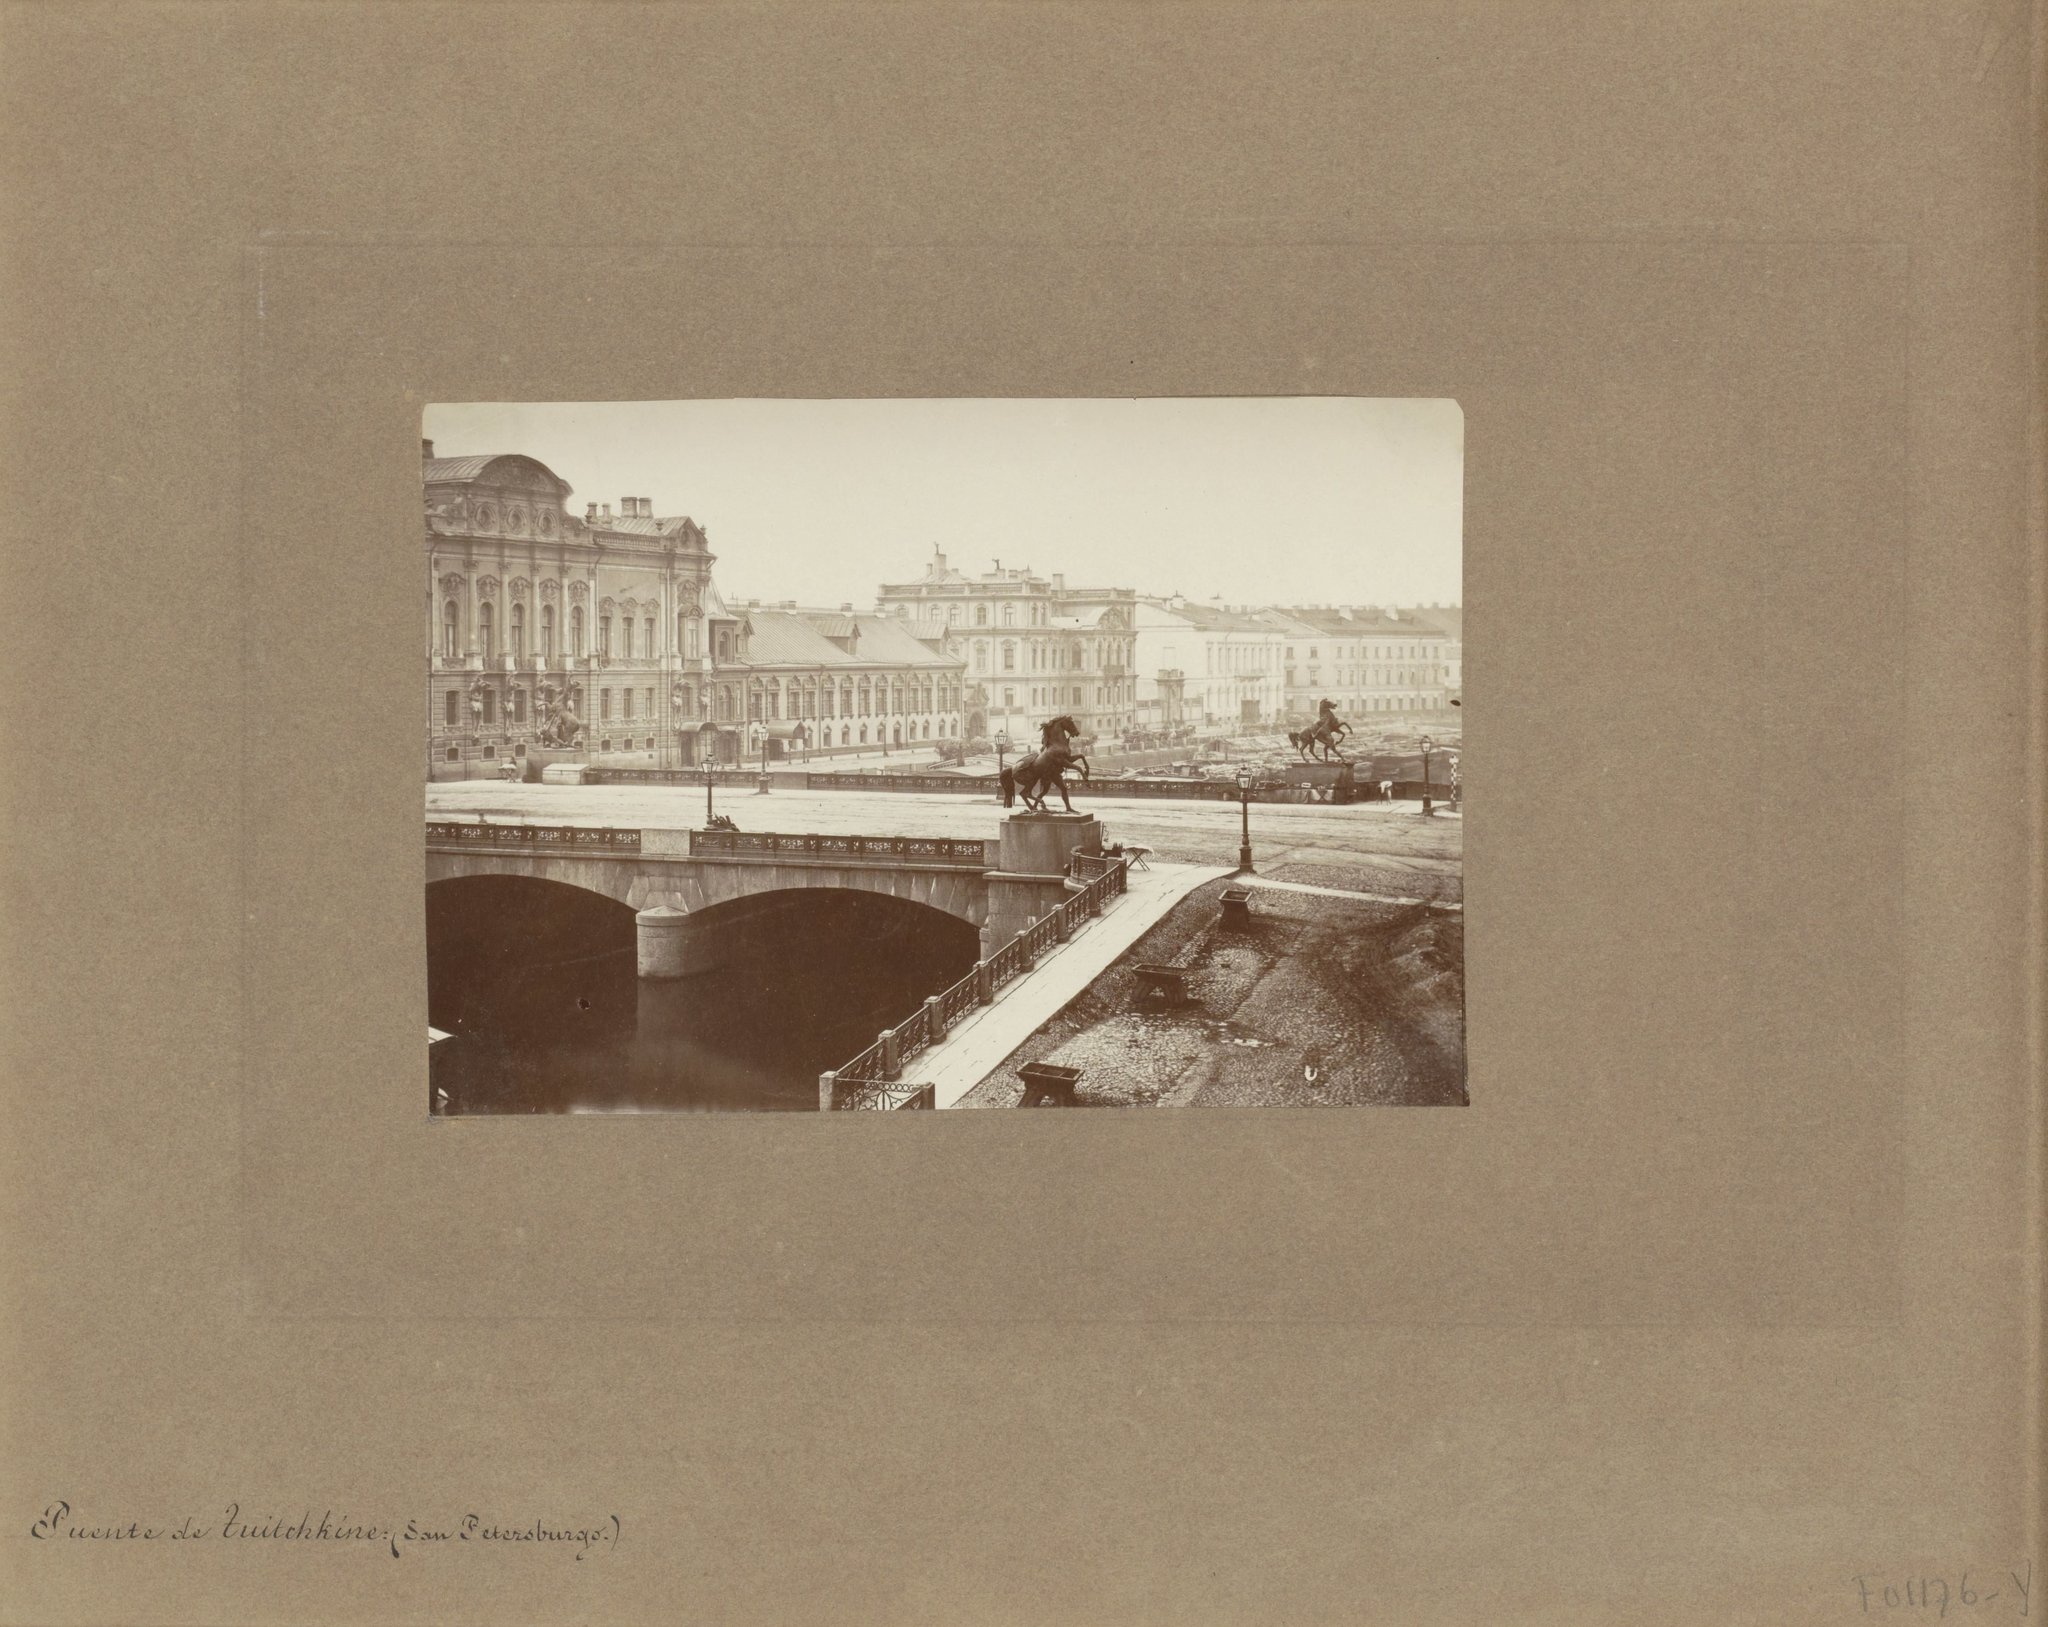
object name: photograph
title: Anichkovbrug met beelden van de paardentemmers in Sint Petersburg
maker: alfred lorens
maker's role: fotograaf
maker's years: 1830-1896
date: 1850-1876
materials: photographic support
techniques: albumen print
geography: sint-petersburg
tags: piece of sculpture, reproduction of a piece of sculpture (+ sculpture), travelling; tourism, bridge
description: Onderdeel van Reisalbum met foto's en tekeningen van Manuel Mayo 1876.